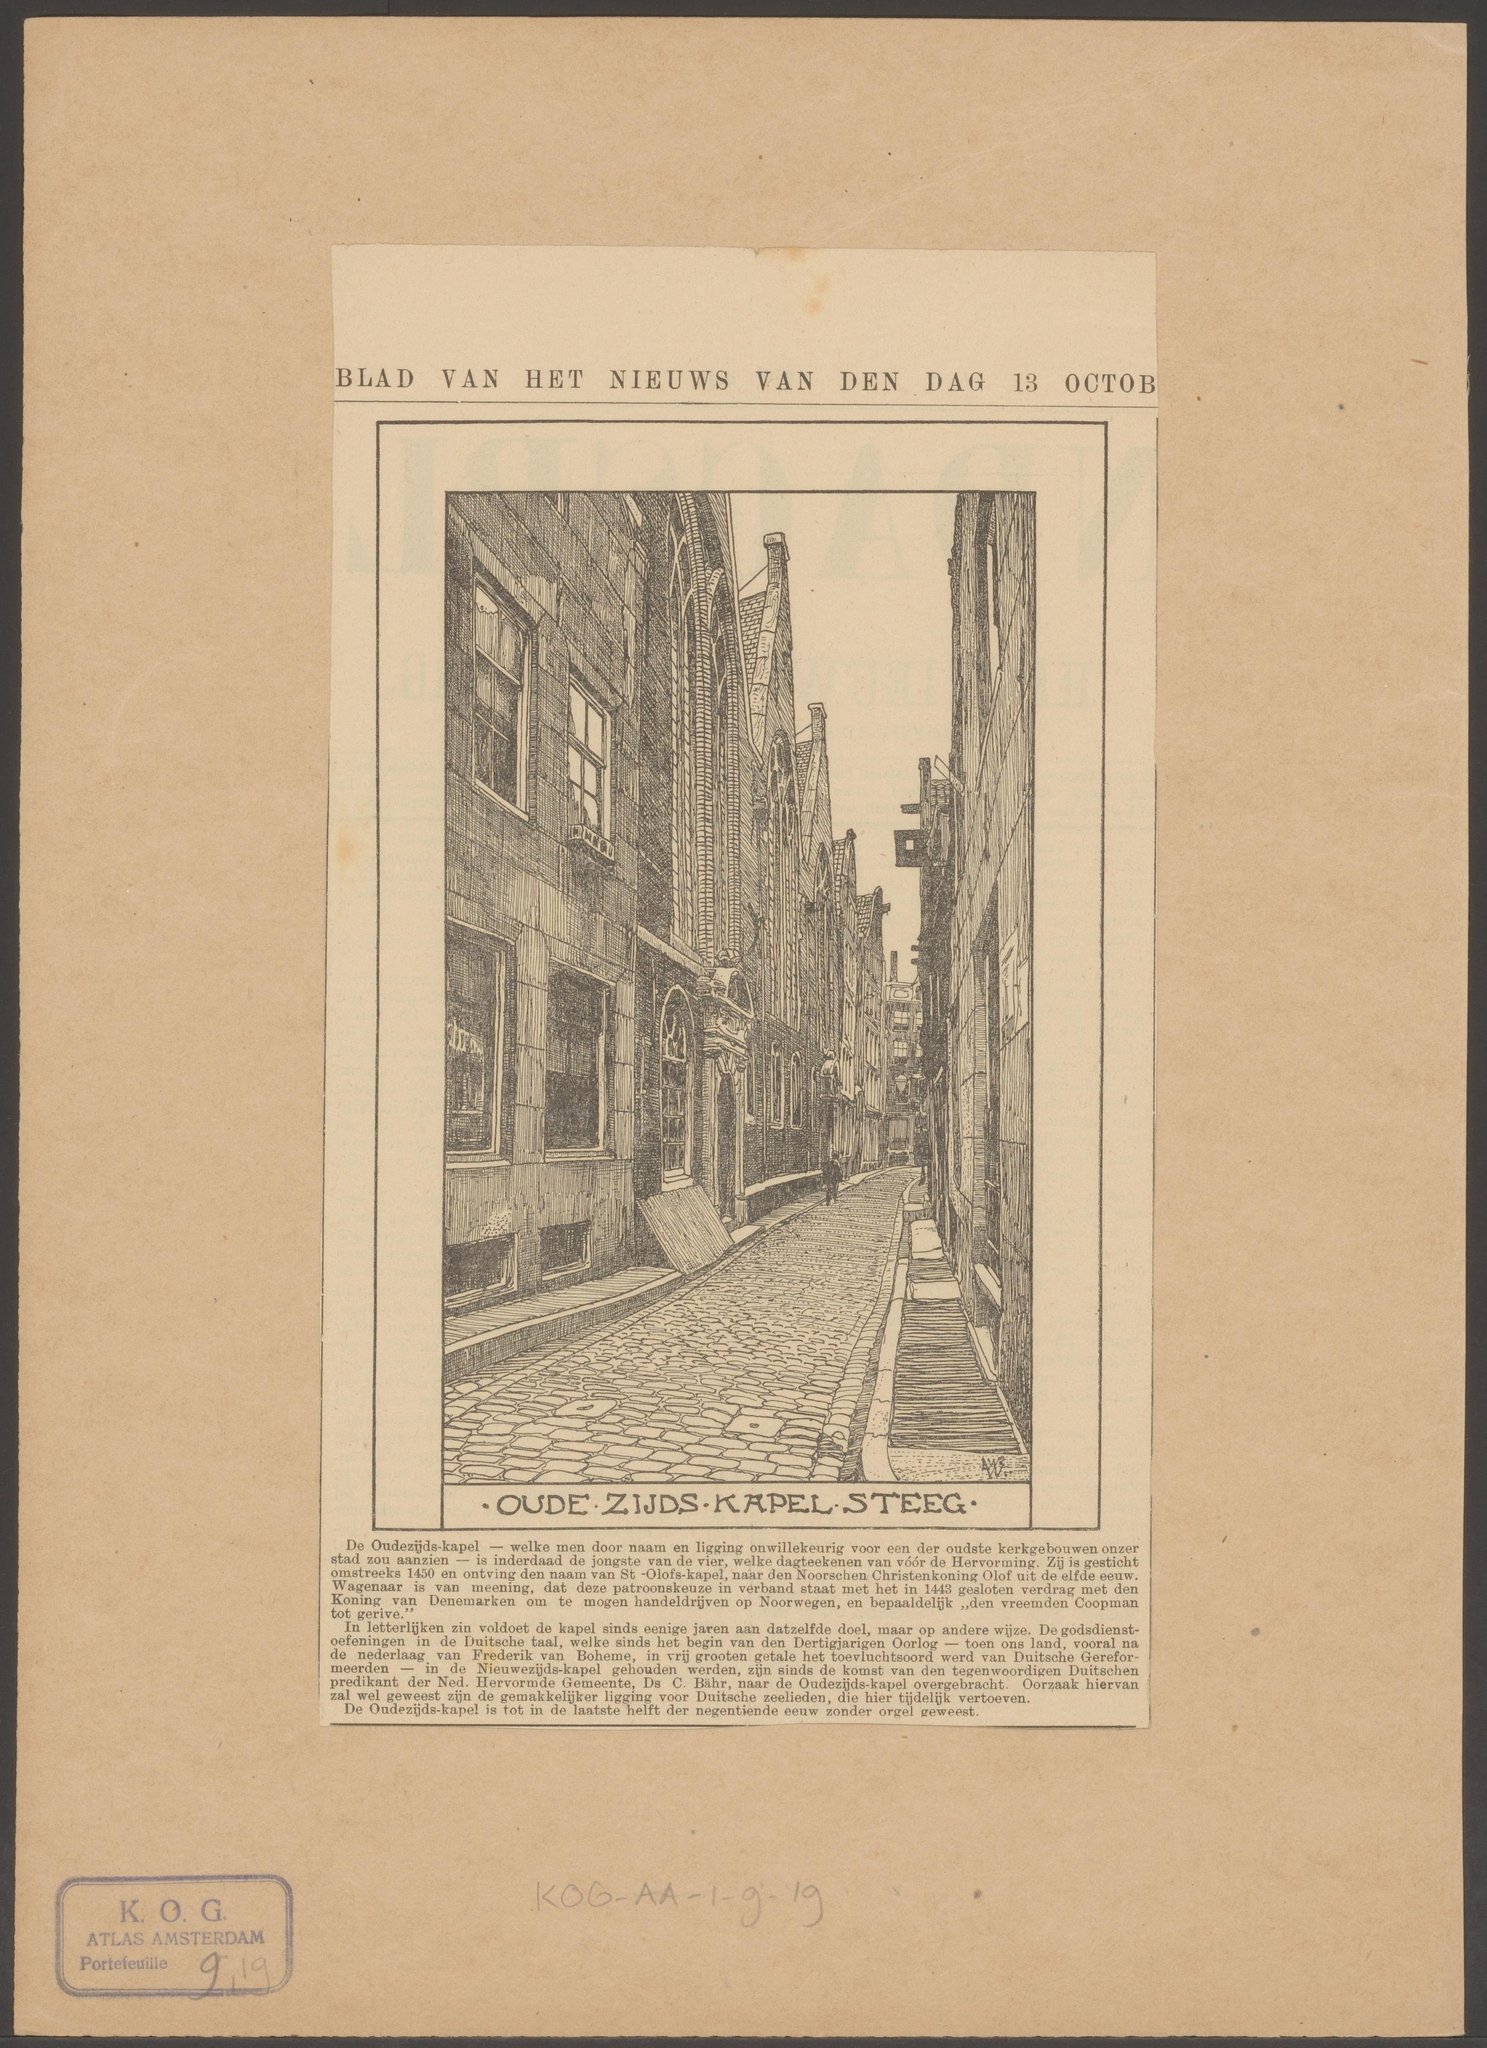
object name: photomechanical print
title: Oud-Amsterdam 100 Stadsgezichten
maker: willem wenckebach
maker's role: designer, draughtsman, painter, print maker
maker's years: 1860-1937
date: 1870-1923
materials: paper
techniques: letterpress printing, line block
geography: amsterdam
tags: city-view in general; 'veduta', the usual house or row of houses, lane, alley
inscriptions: collector's mark: ‘9,19’ Lugt 1641b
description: Onderwerpsrubriek binnen de Atlas Amsterdam: Kadijksplein, Karthuizerkerkhof, Kattegat, Kattenburg, Kapelsteeg O.Z., Enge Kerksteeg, Kerkstraat, Kinkerstraat, Kolk O.Z., Koningsplein, Kromboomsloot [Krom Boomssloot], Kostverlorenkade, Kwakersdwarspad, Kalverstraat, Keizersgracht (v.d. Brouwersgracht – Amstel), Klerensloot (Gedempte), Klimopstraat, Kloveniersburgwal, Kraansluis.